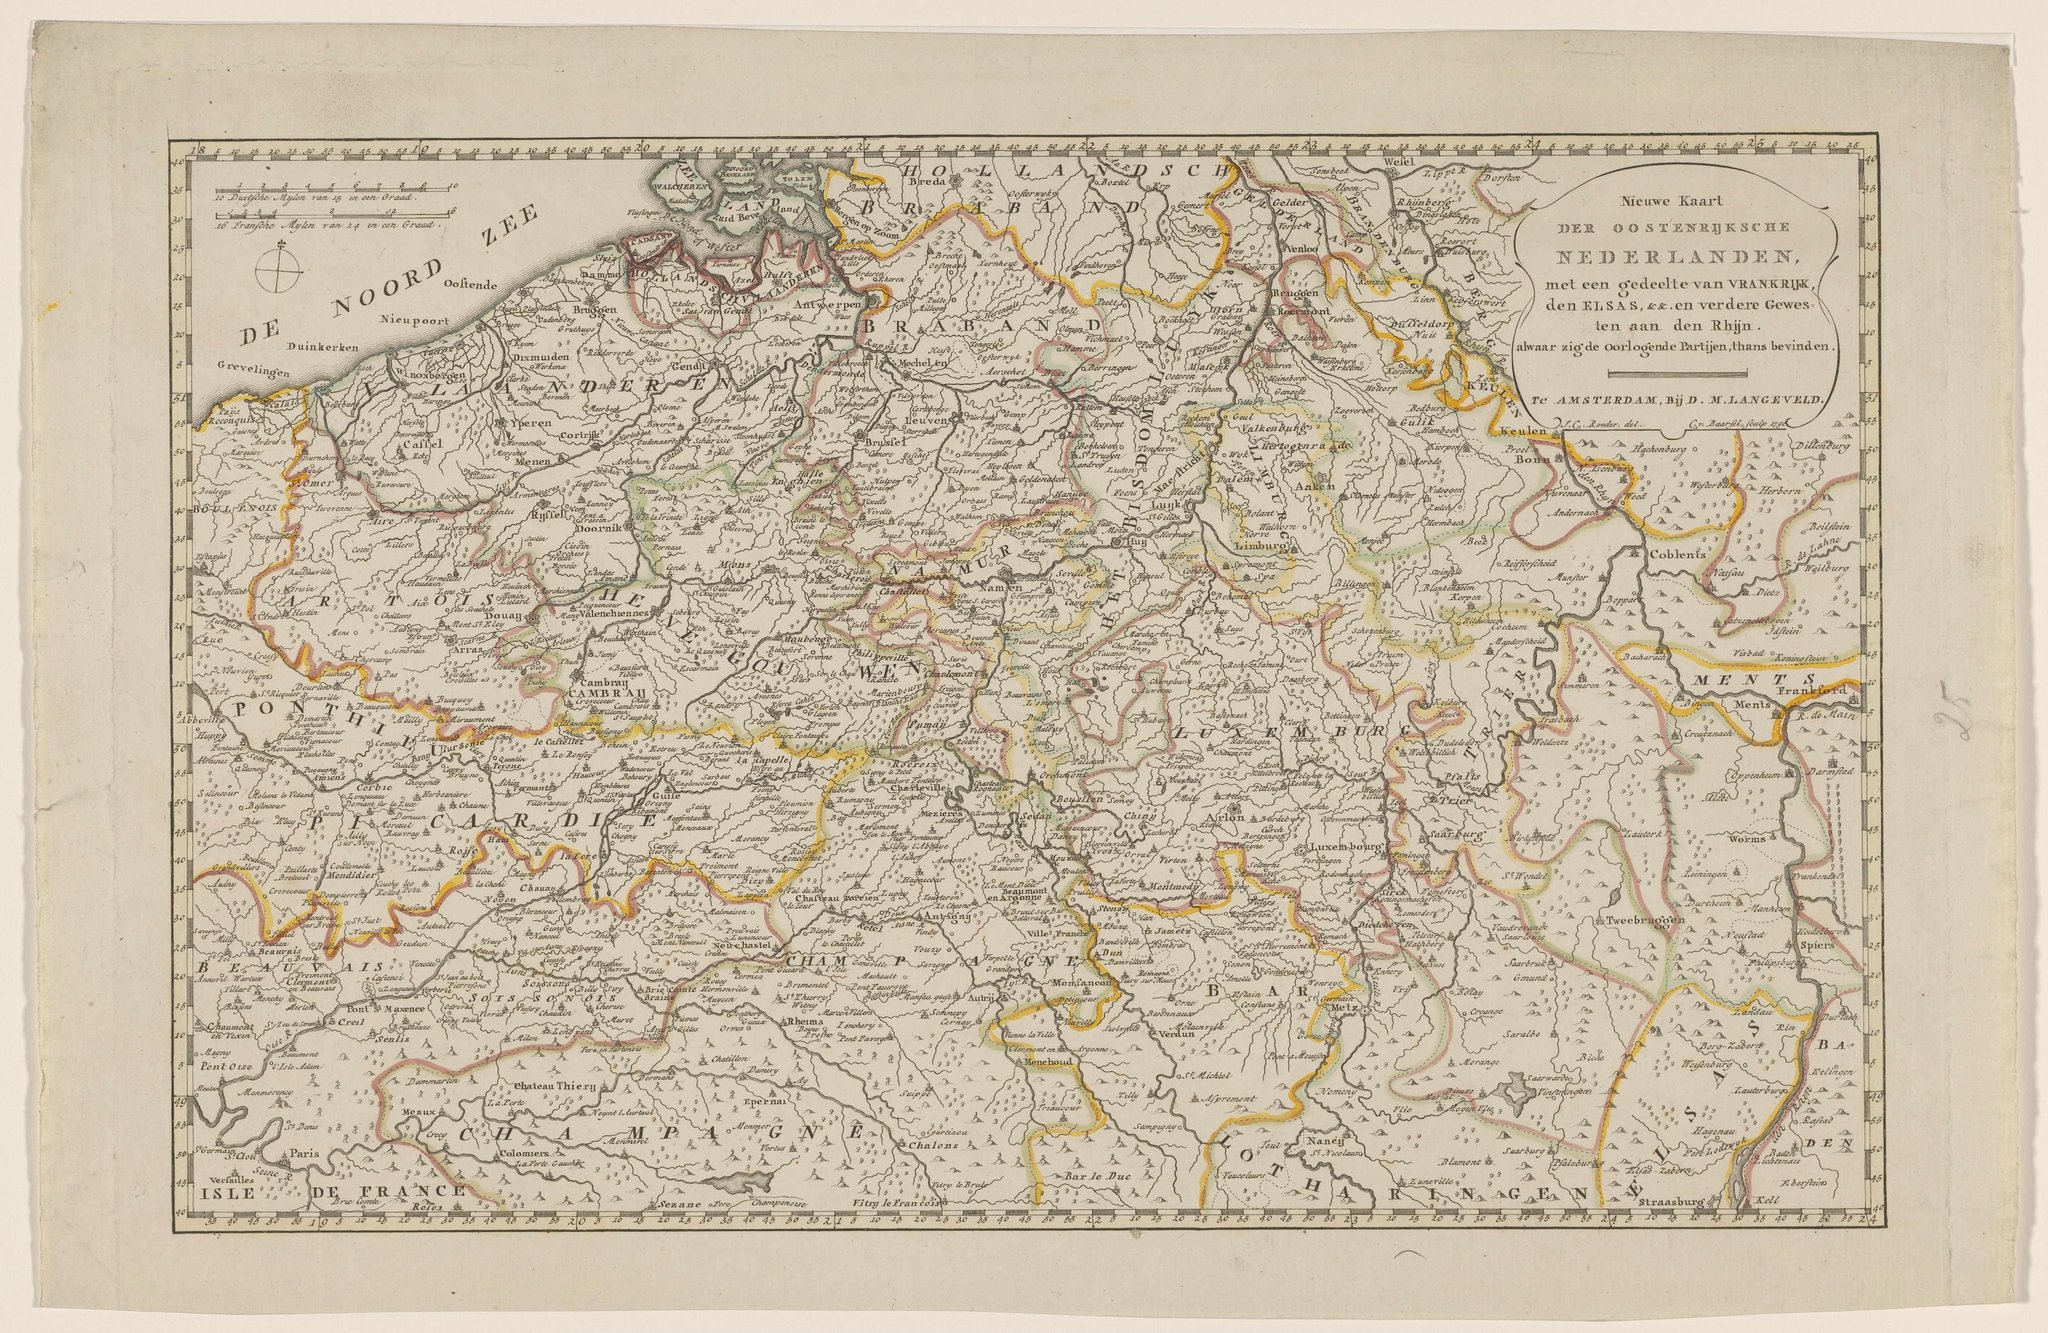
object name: map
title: Nieuwe kaart der Oostenrijksche Nederlanden, met een gedeelte van Vrankrijk (...) alwaar zig de oorlogende Partijen, thans bevinden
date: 1792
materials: paper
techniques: engraving, etching, hand coloring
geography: northern netherlands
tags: maps of separate countries or regions, southern netherlands, belgium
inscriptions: collector's mark: Lugt 2228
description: Kaart van de Oostenrijkse Nederlanden ten tijde van de Eerste Coalitie-oorlog met de Fransen in 1792. Rechtsboven de titelcartouche. Linksboven twee schaalstokken: 10 Duitsche Mylen van 15 in een Graad / 16 Fransche Mylen van 24 in een Graad. De kaart is voorzien van een gradenverdeling langs de randen.